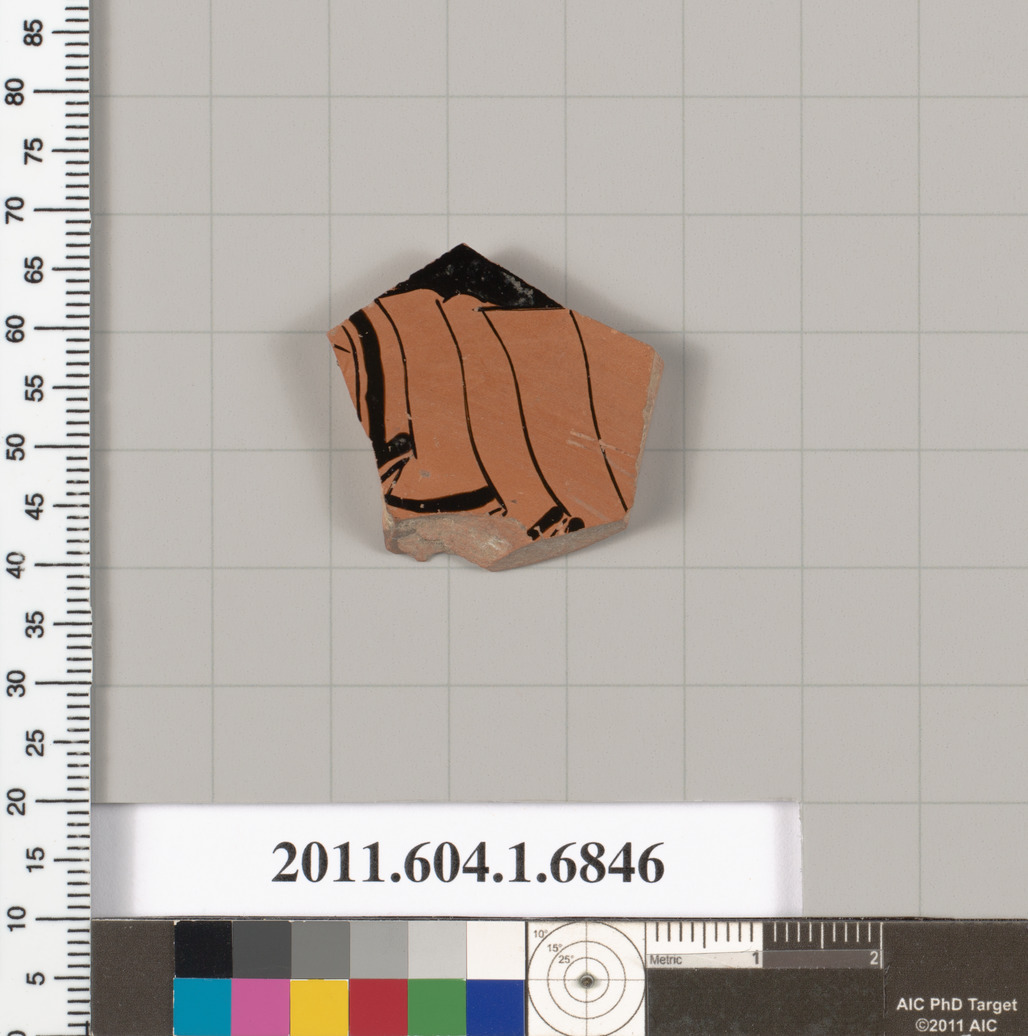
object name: kylix fragment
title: Terracotta fragment of a kylix (drinking cup)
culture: greek, attic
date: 490-470 BCE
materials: terracotta